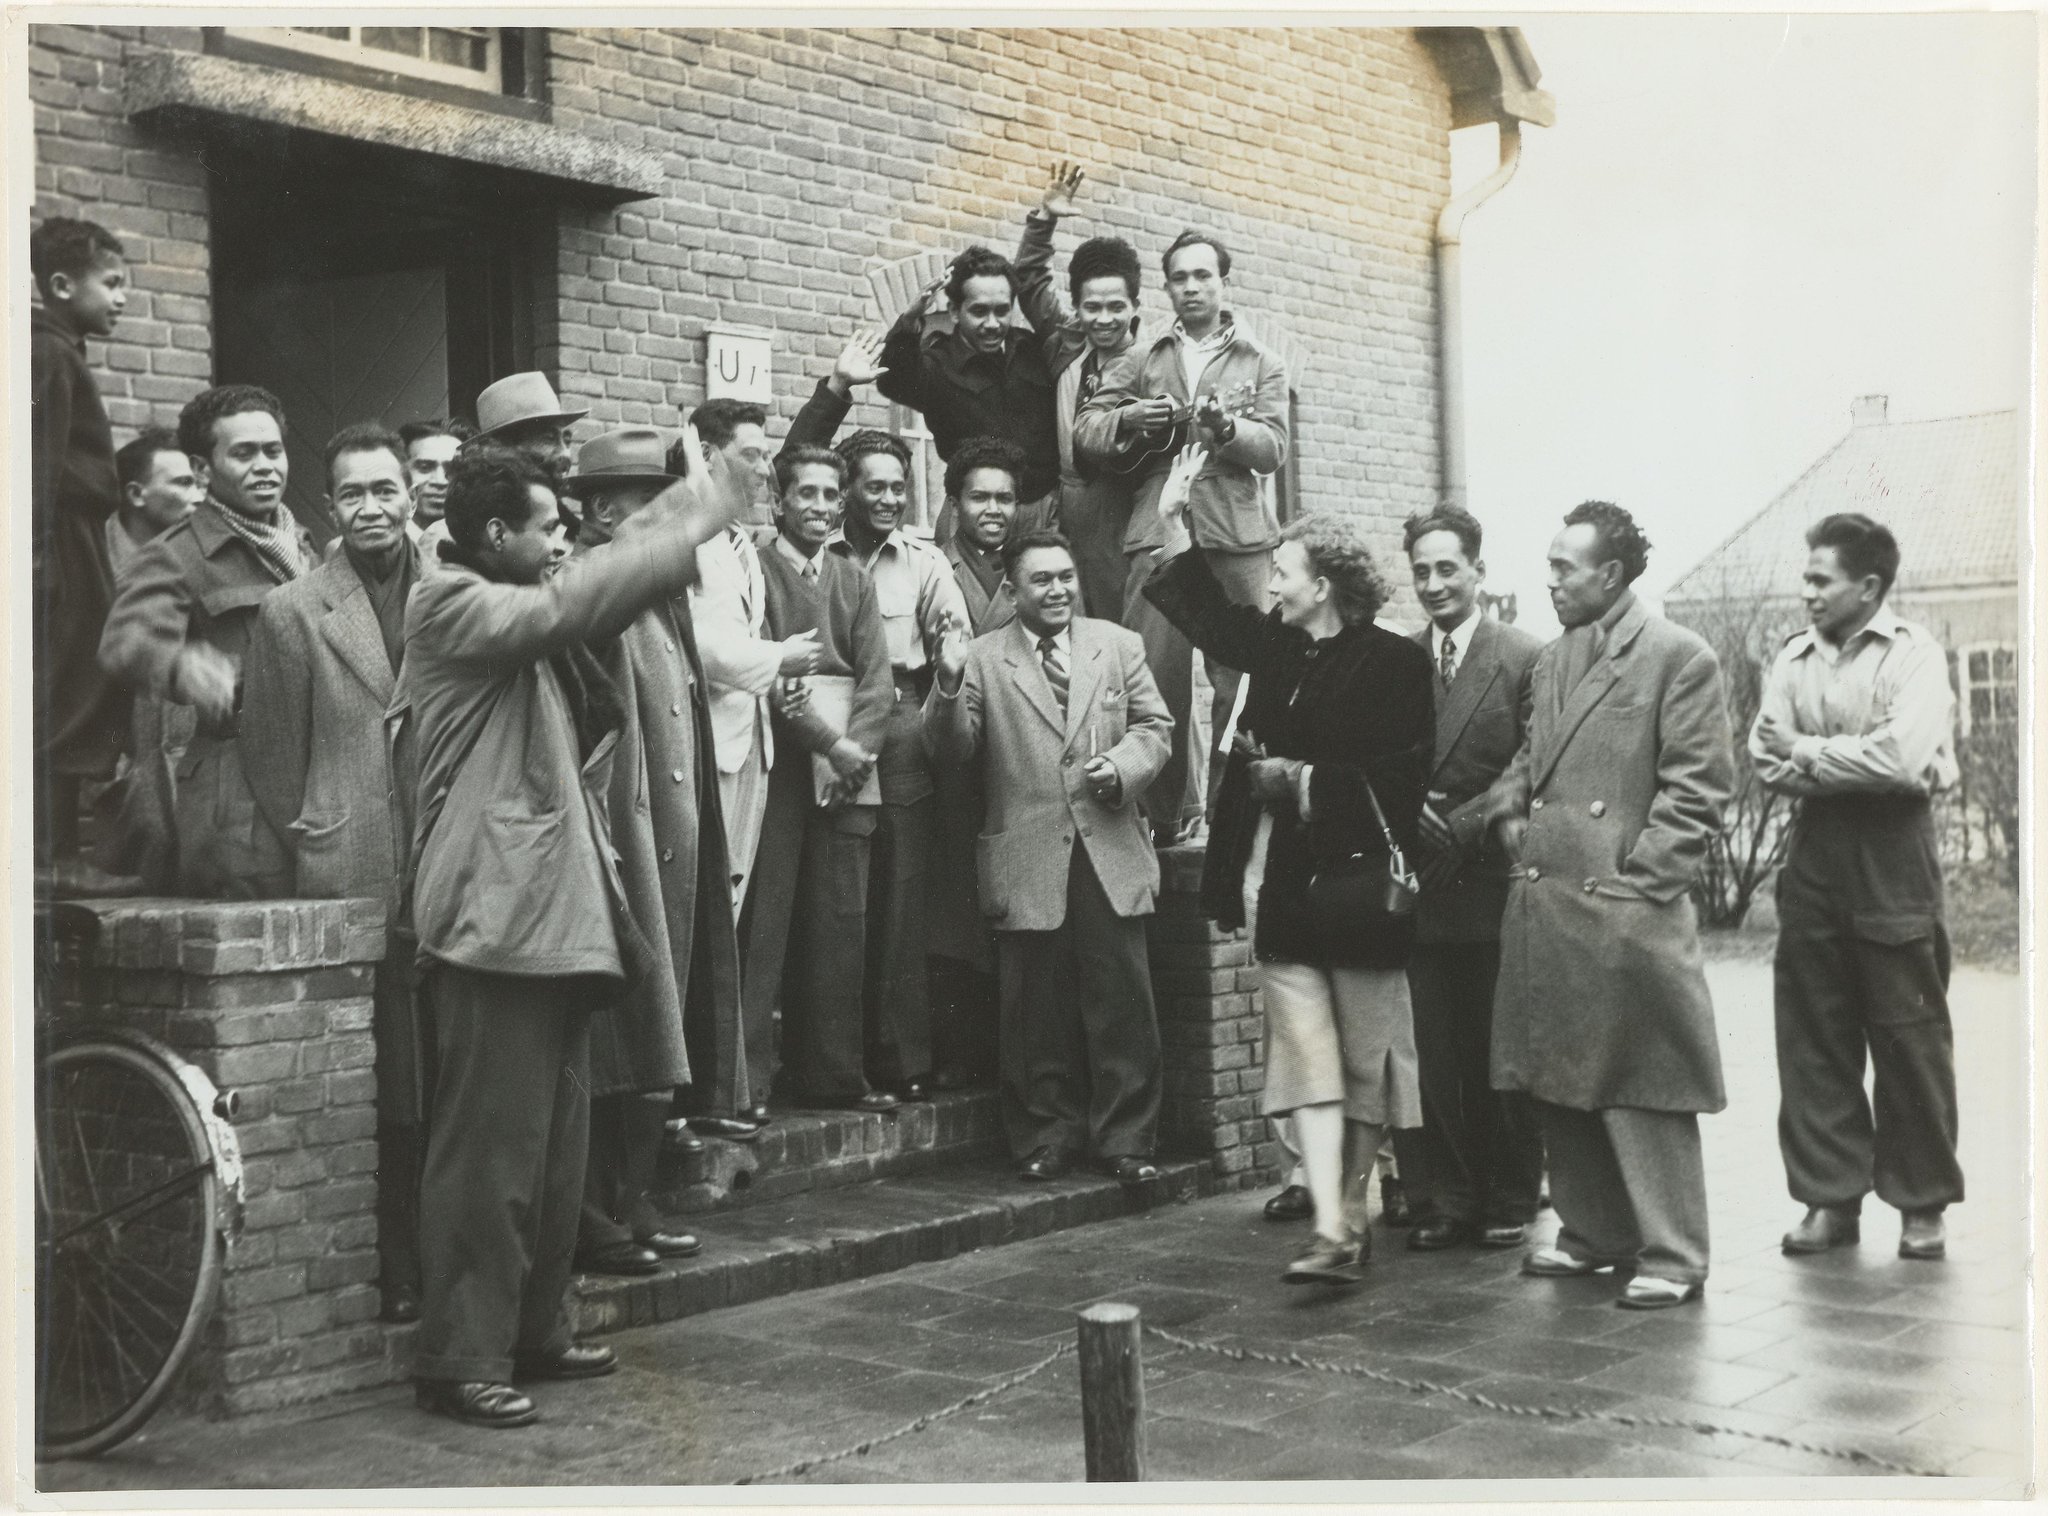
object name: photograph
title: Groep Ambonese mannen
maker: e. de vries (fotograaf)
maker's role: fotograaf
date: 1951-1955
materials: photographic support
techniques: photography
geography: netherlands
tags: netherlands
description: Een grote groep Ambonezen staat voor een gebouw en zwaait naar een Nederlandse vrouw.